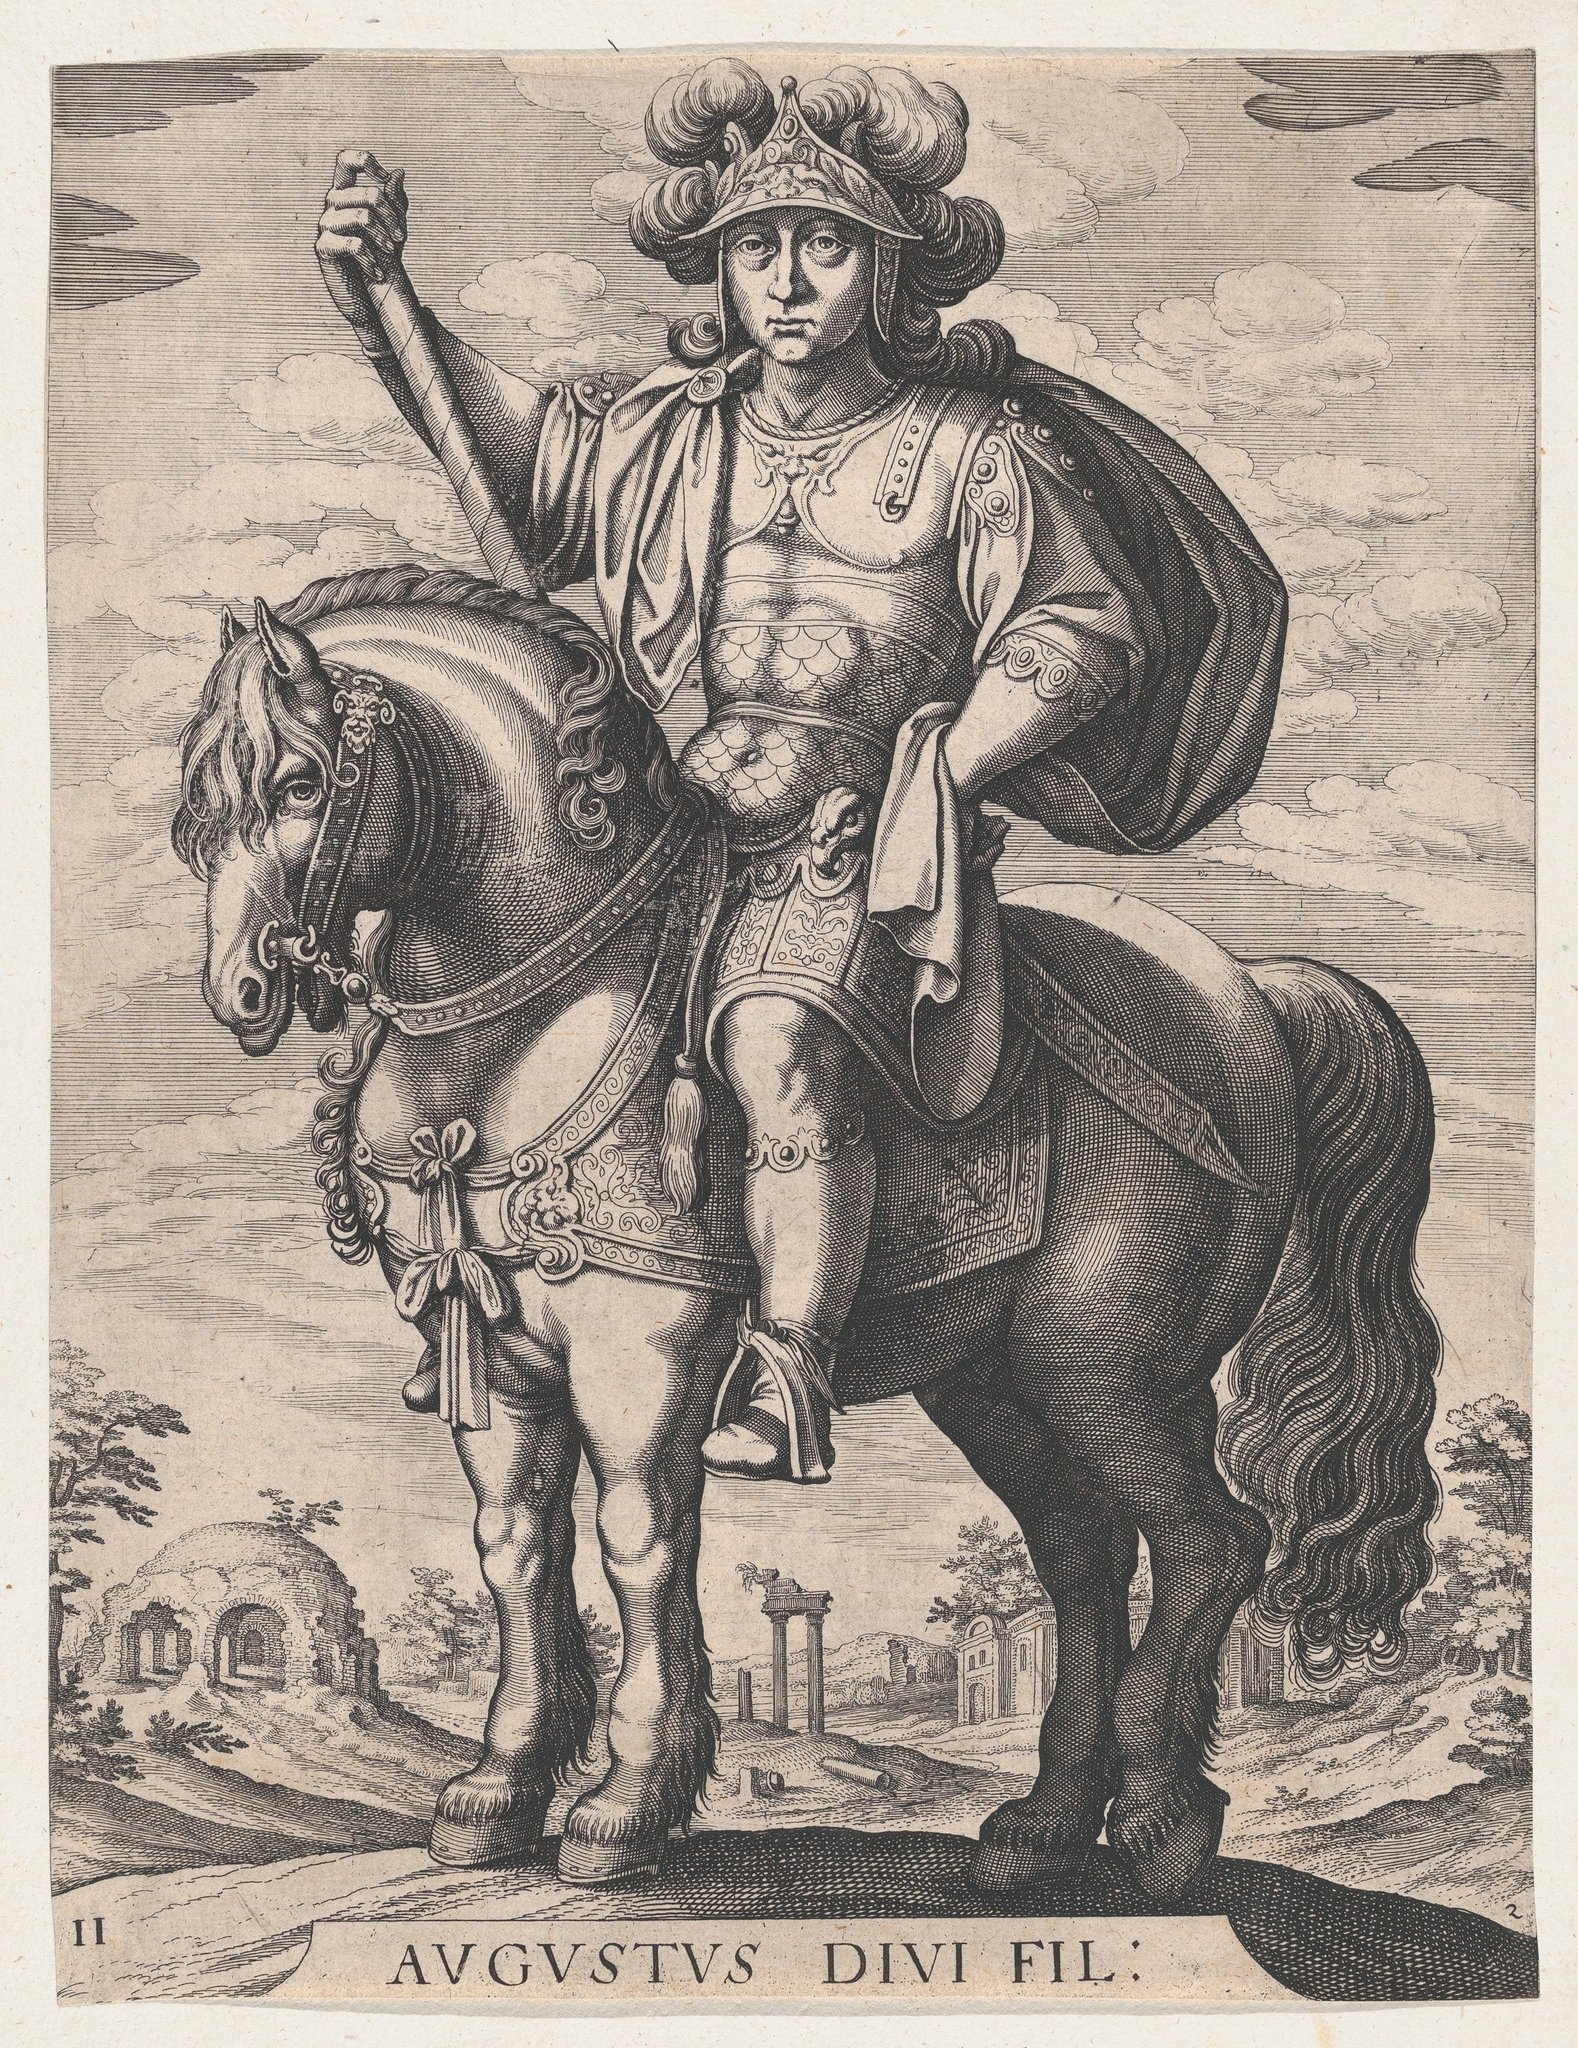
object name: print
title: Plate 2: Emperor Augustus on Horseback, from 'The First Twelve Roman Caesars', after Tempesta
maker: matthäus merian the elder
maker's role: artist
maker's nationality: swiss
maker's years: 1593-1650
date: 1610-1650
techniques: engraving, etching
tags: emperor augustus,portraits,horses